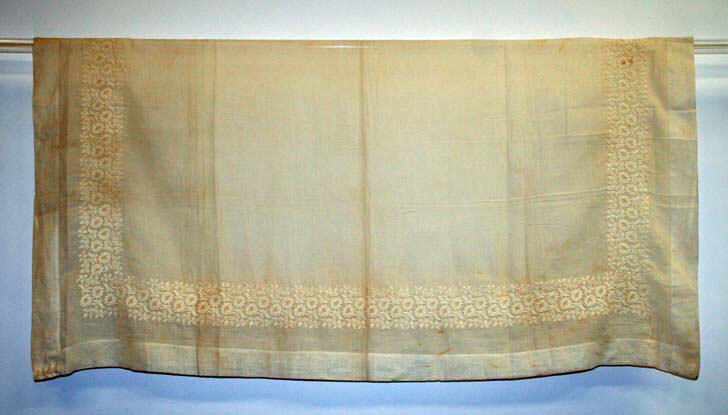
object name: scarf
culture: american or european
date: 1804-1815